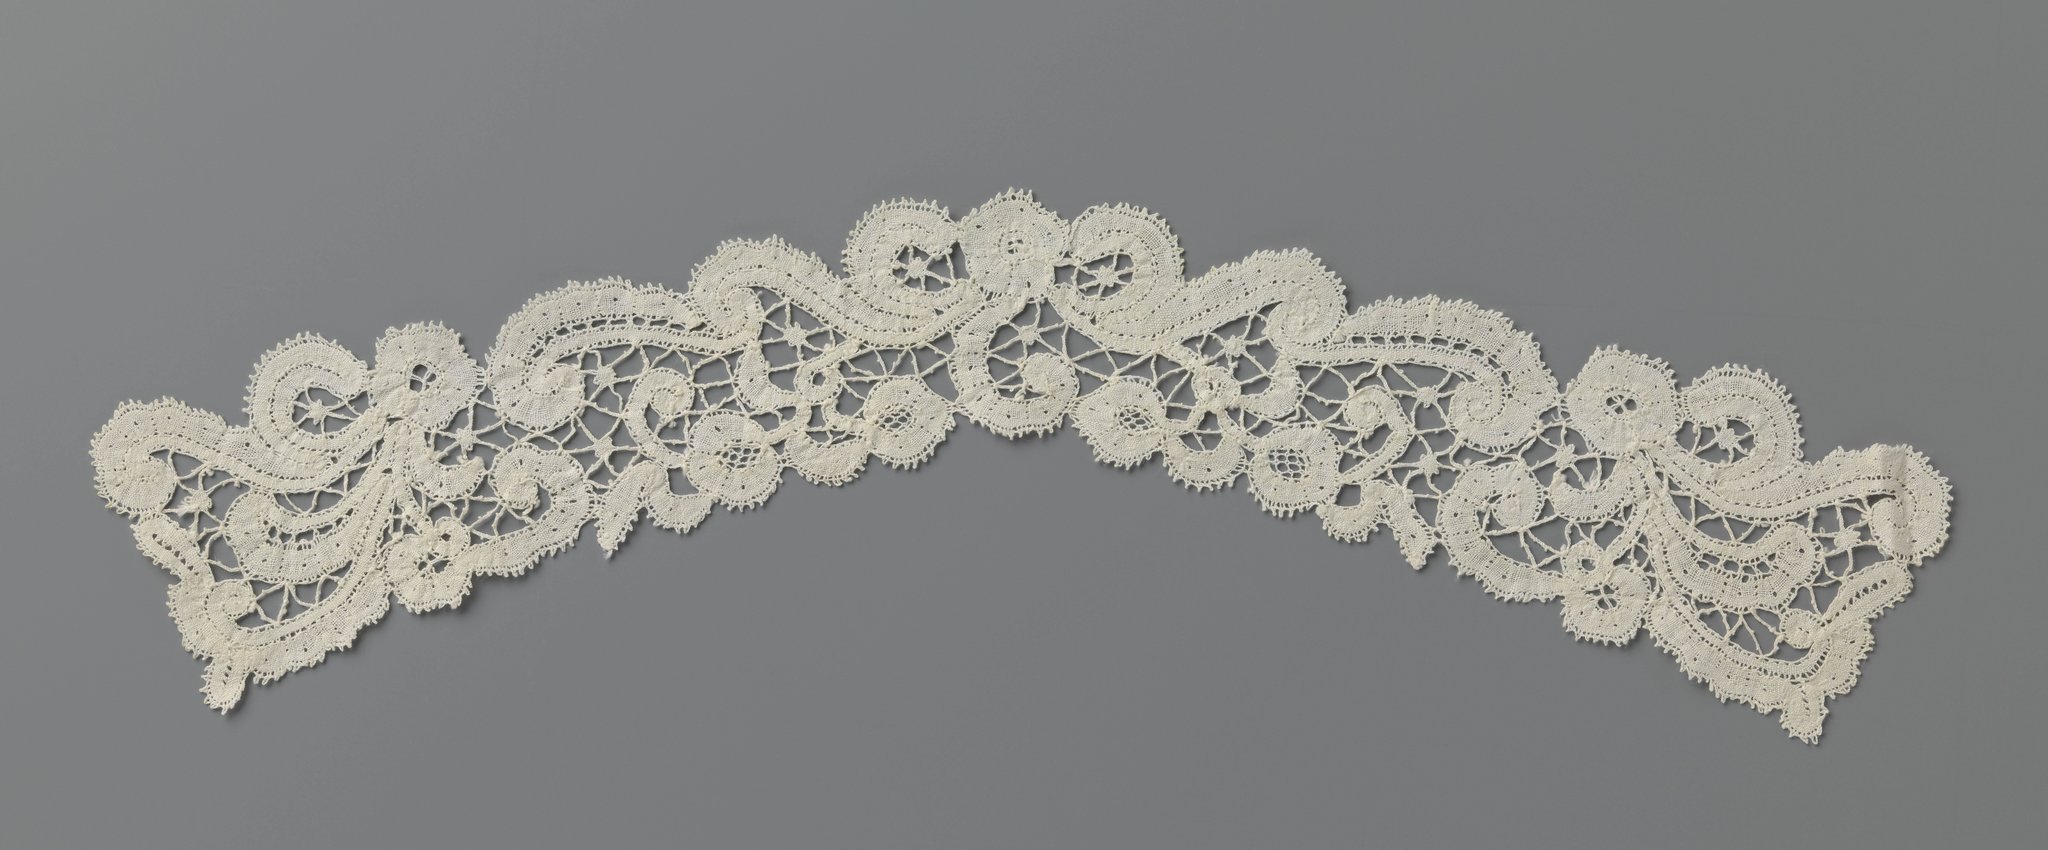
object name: guimpe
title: Guimpe van kloskant met symmetrisch voluten patroon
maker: leon sacré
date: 1907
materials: linen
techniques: lace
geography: brussels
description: Guimpe van naturelkleurige kloskant: Vlaamse guipure. Symmetrische patroon van s-voluten en c-voluten waartussen in totaal drie rondvormige bloemen of vruchten en drie rozetbloemen. Vlechtengrond. Afwerking aan alle zijden met ongelijke schulpen, die voortkomen uit het patroon. De guimpe is flauw gebogen rechthoekig.